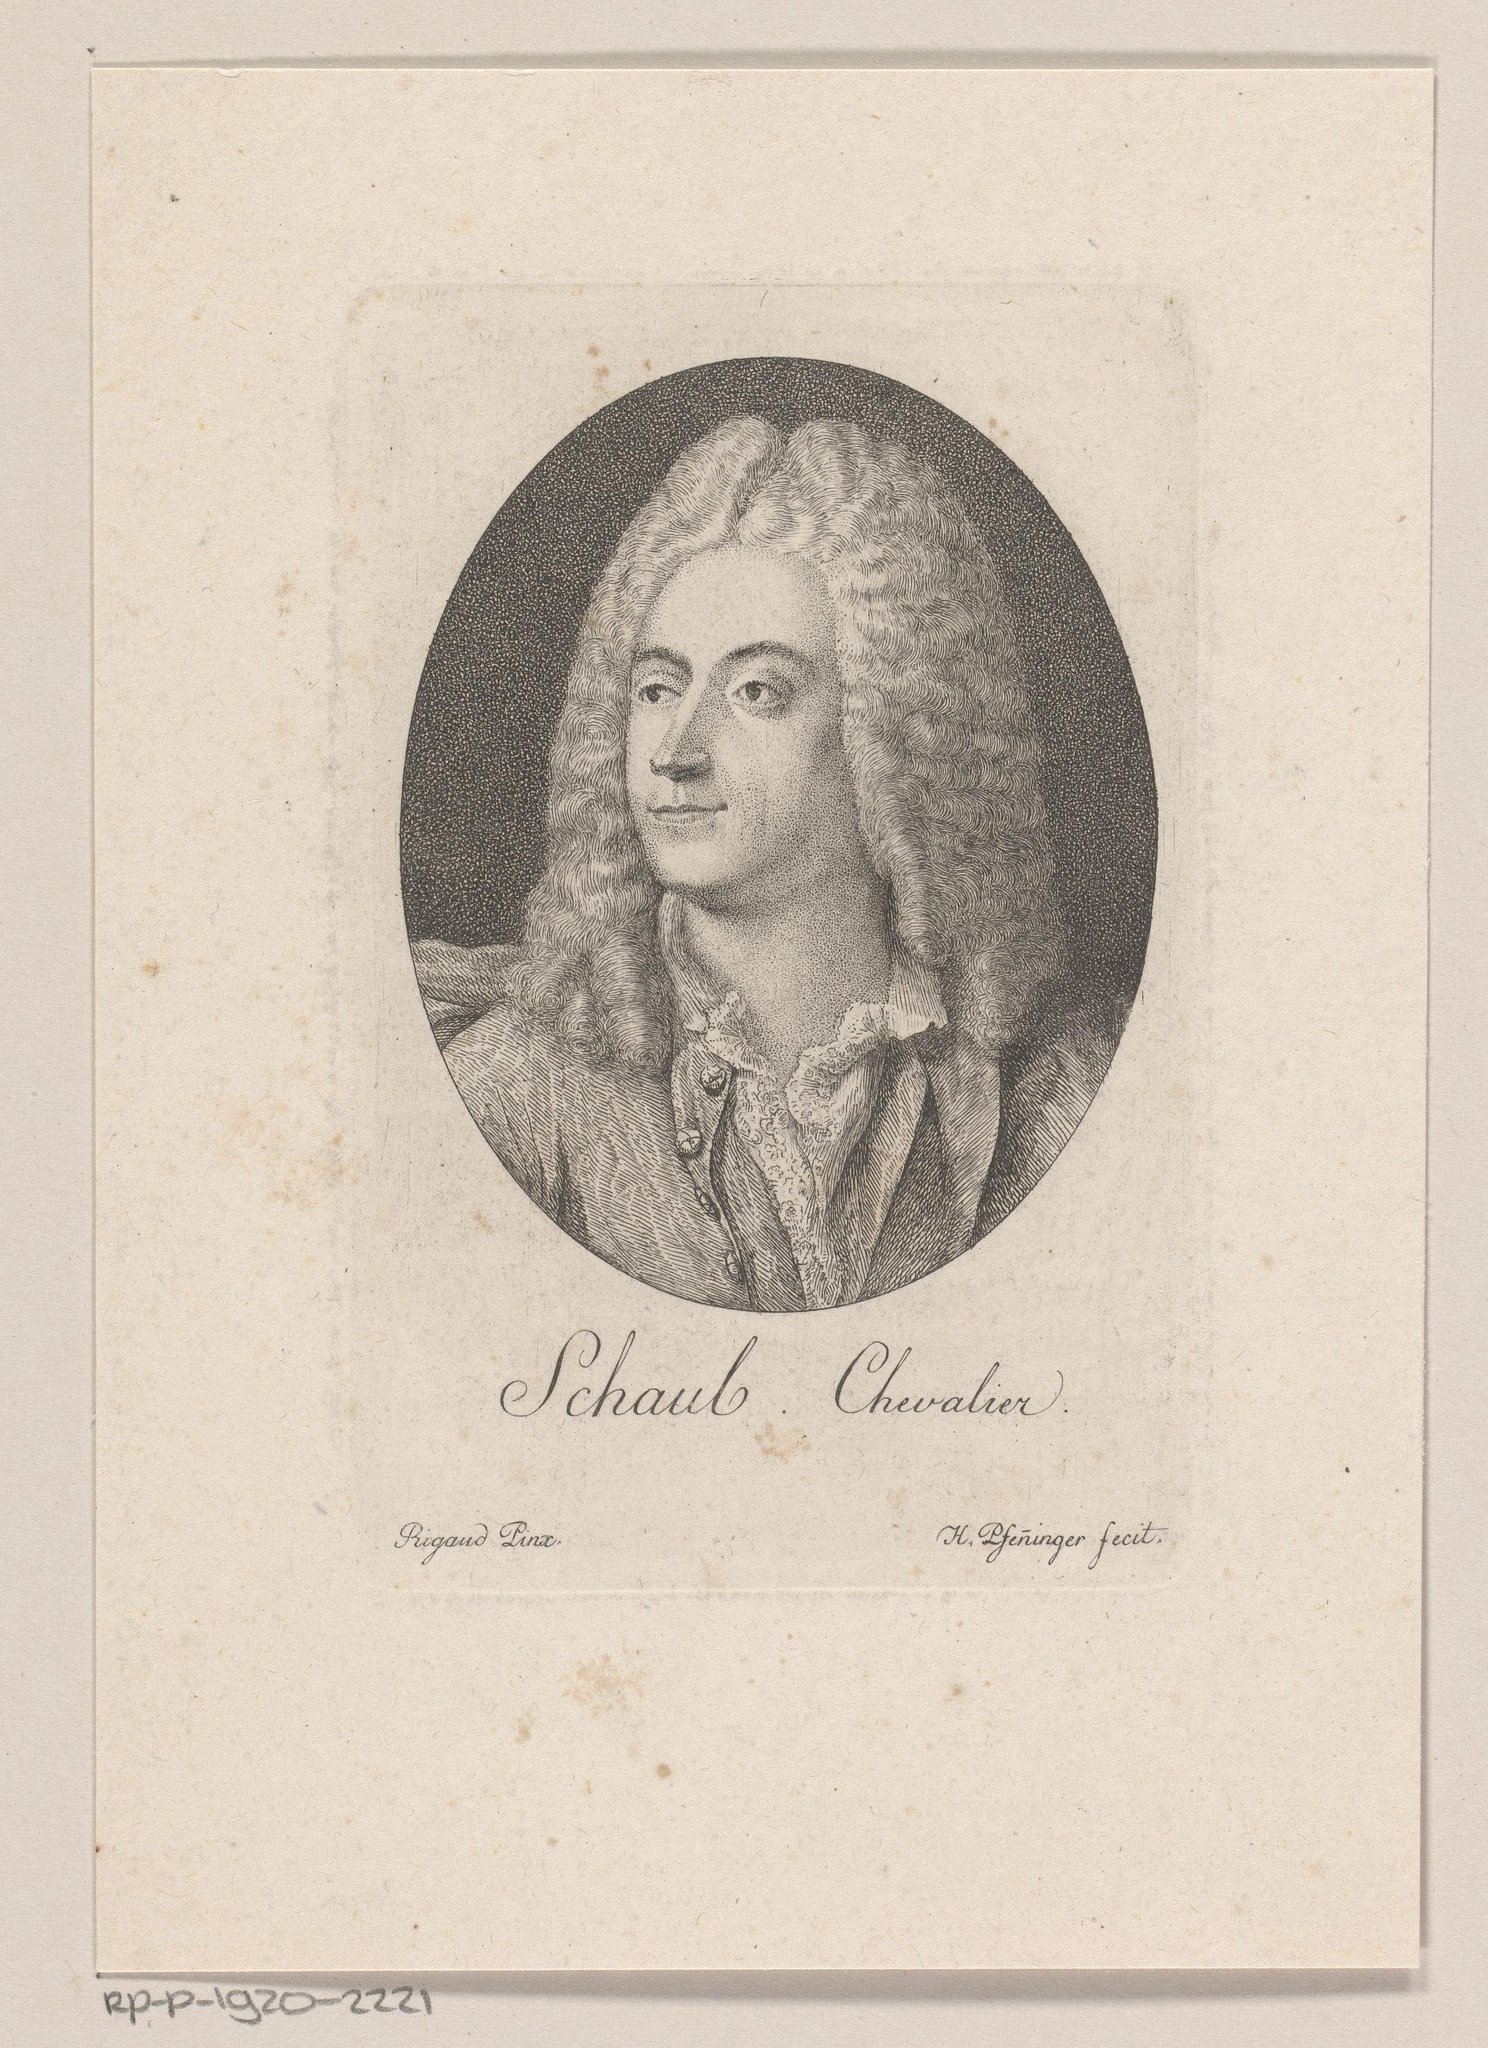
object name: print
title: Portret van Luke Schaub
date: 1759-1815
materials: paper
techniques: etching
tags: historical persons, diplomacy, diplomat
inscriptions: collector's mark: Lugt 2228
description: Met eenregelig onderschrift in het Frans.